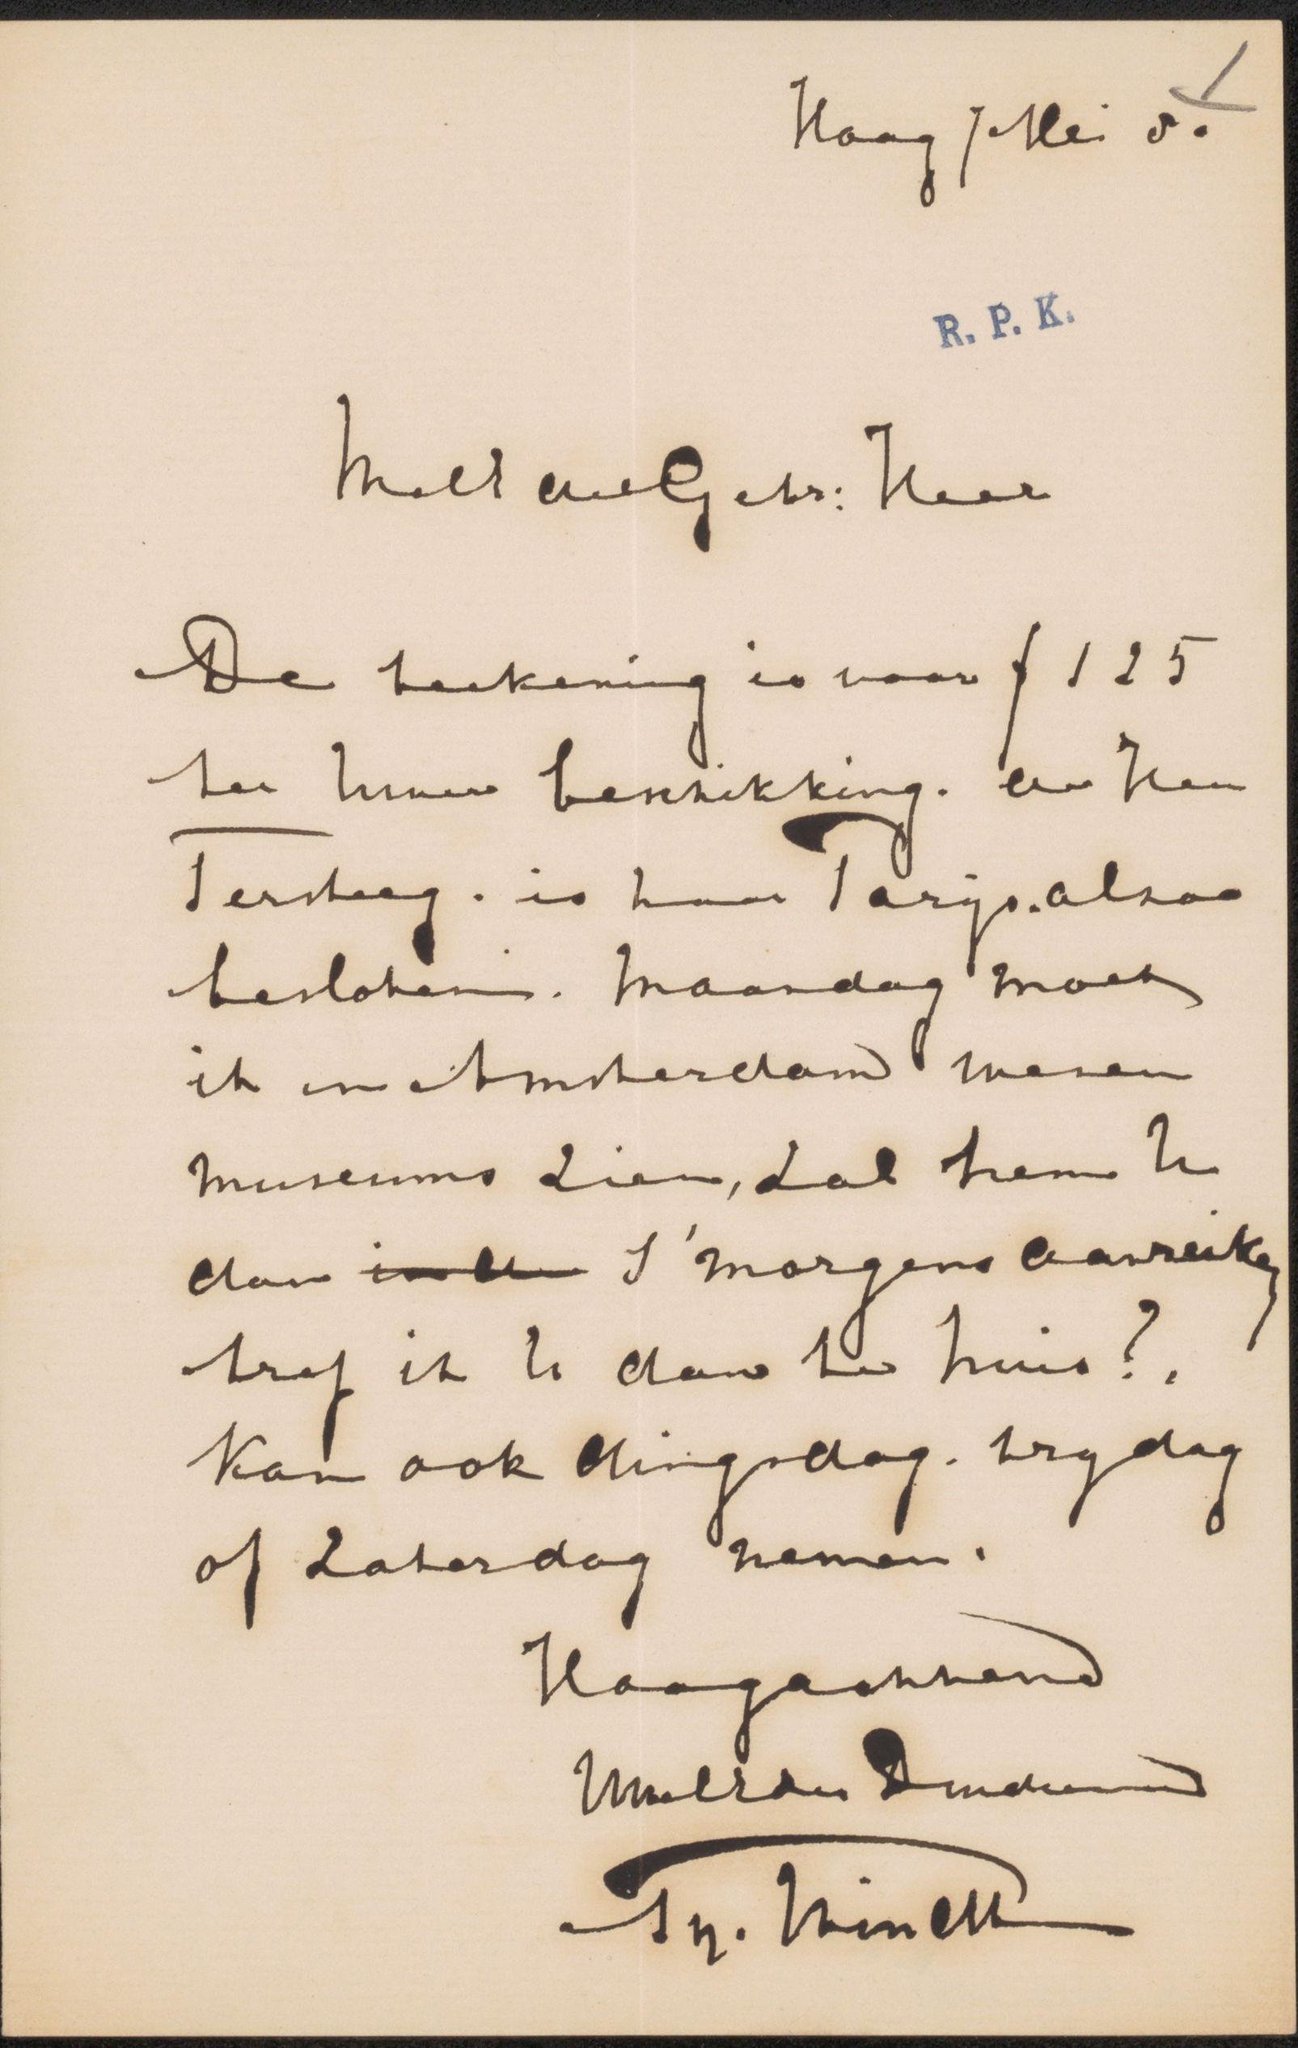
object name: letter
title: Brief aan Frans Buffa en Zonen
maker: philip windt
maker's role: draughtsman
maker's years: 1847-1921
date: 1880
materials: ink, paper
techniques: pen, writing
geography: the hague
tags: publisher, hermanus gijsbertus tersteeg, drawing, money, paris, amsterdam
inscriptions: collector's mark: Lugt 2233